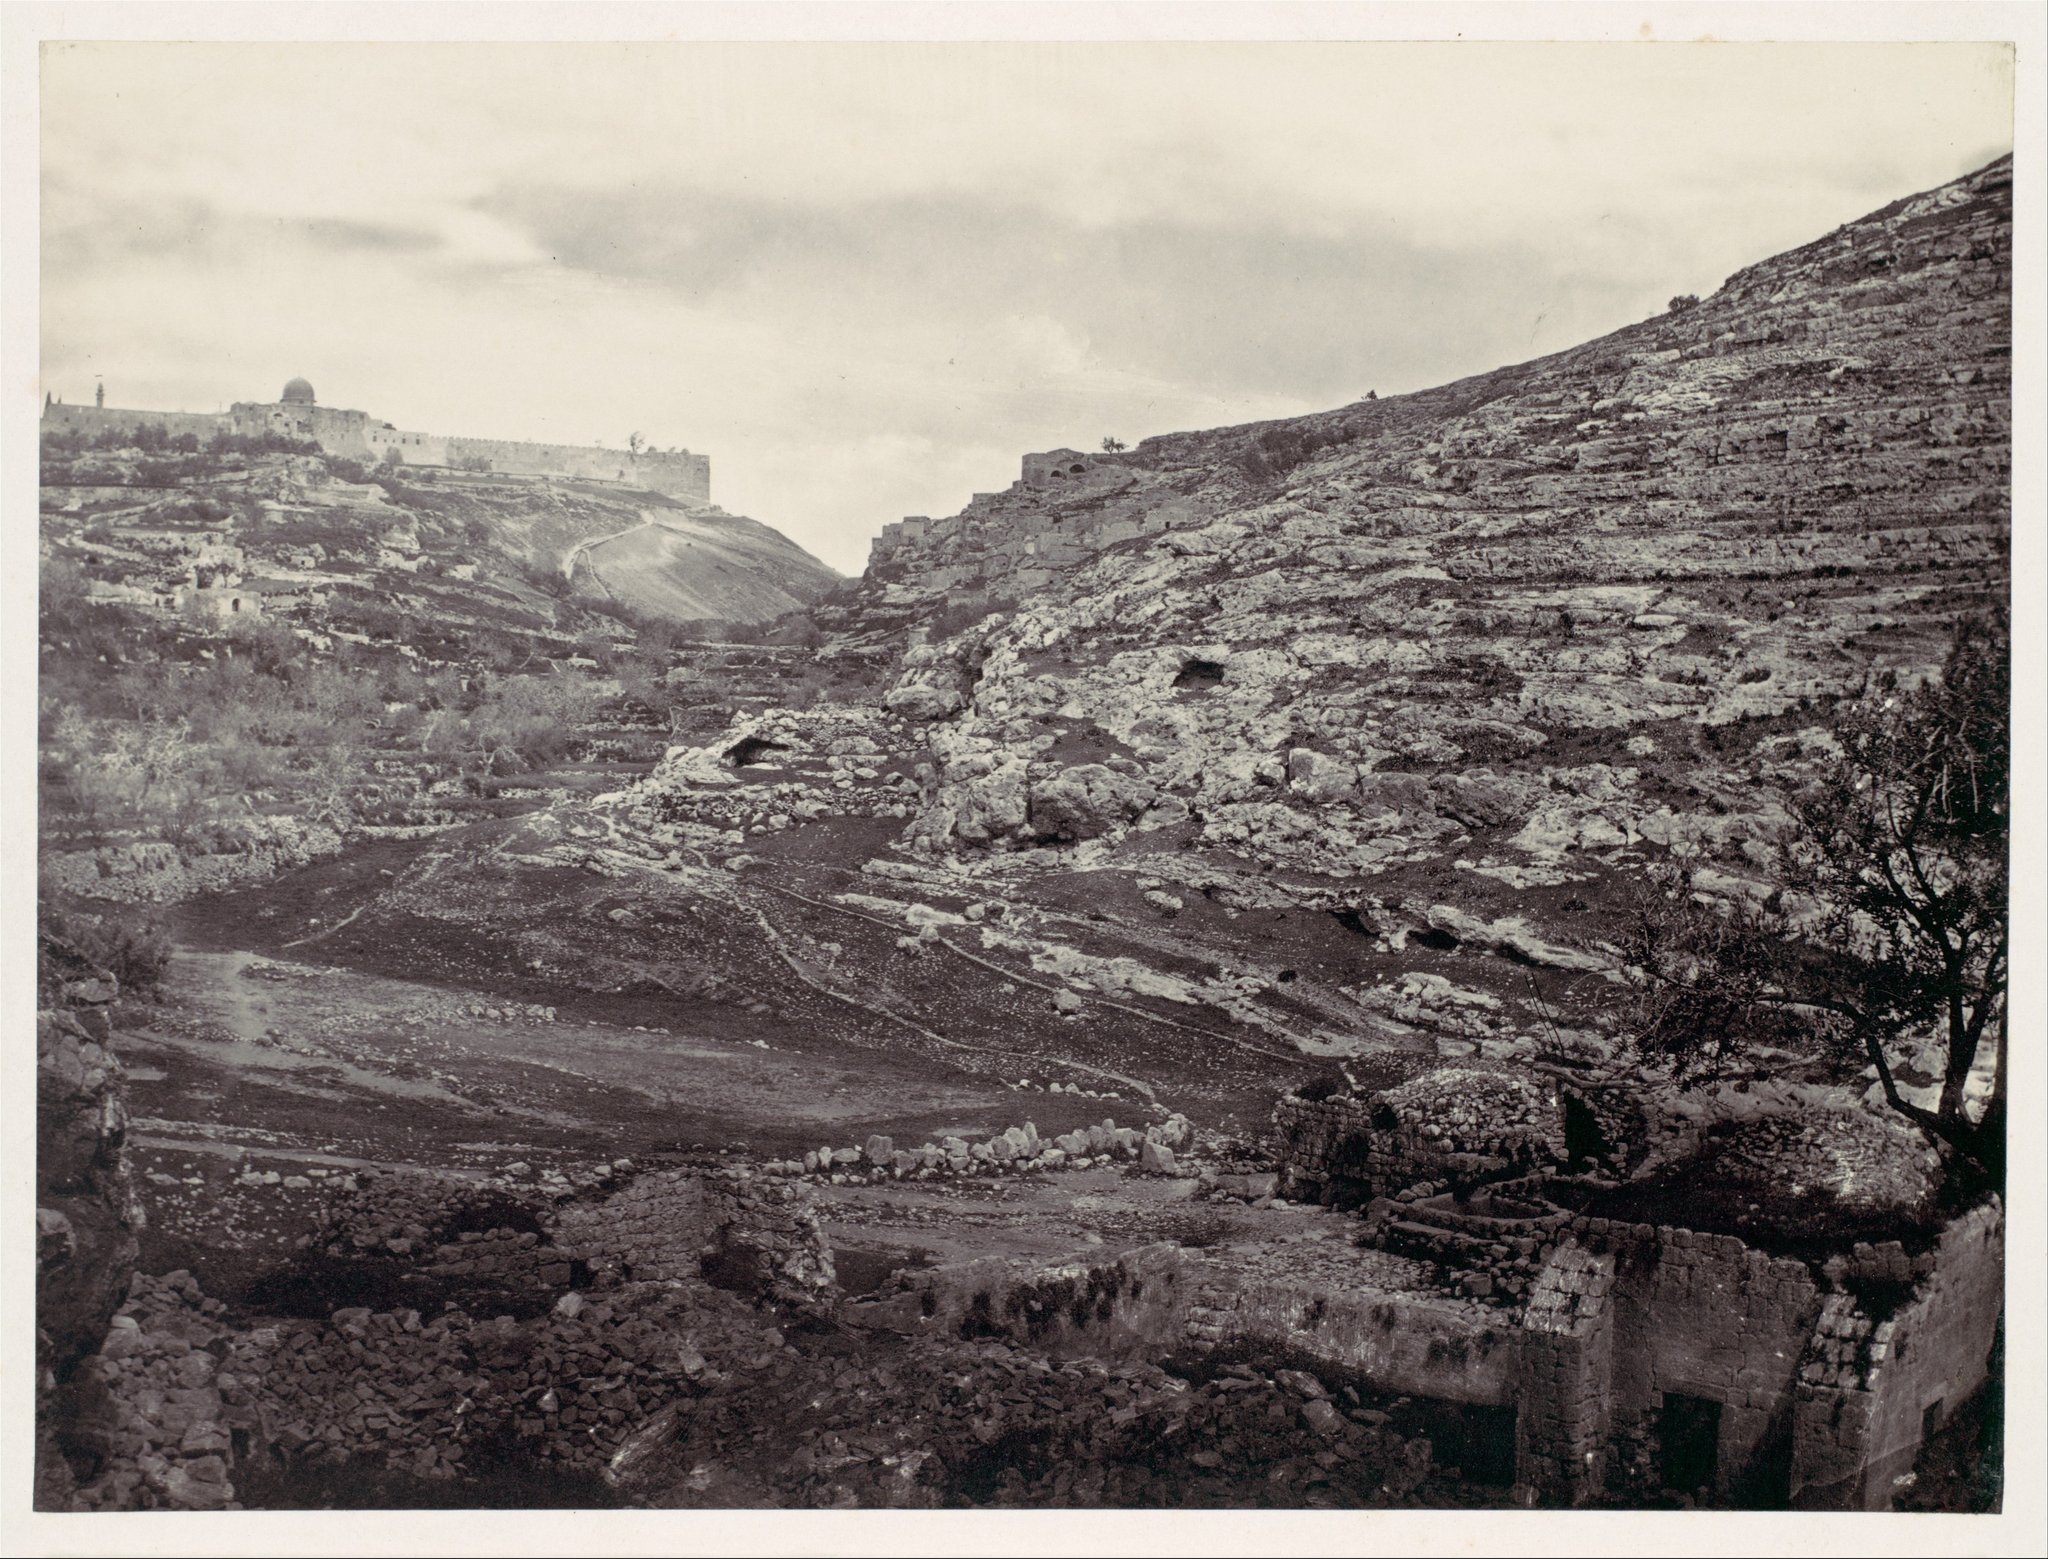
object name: photograph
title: Mount Moriah, Jerusalem, from the Well of En Rogel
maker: francis frith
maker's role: publisher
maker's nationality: english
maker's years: 1822-1898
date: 1857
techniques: albumen silver print, glass negative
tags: mountains,landscapes